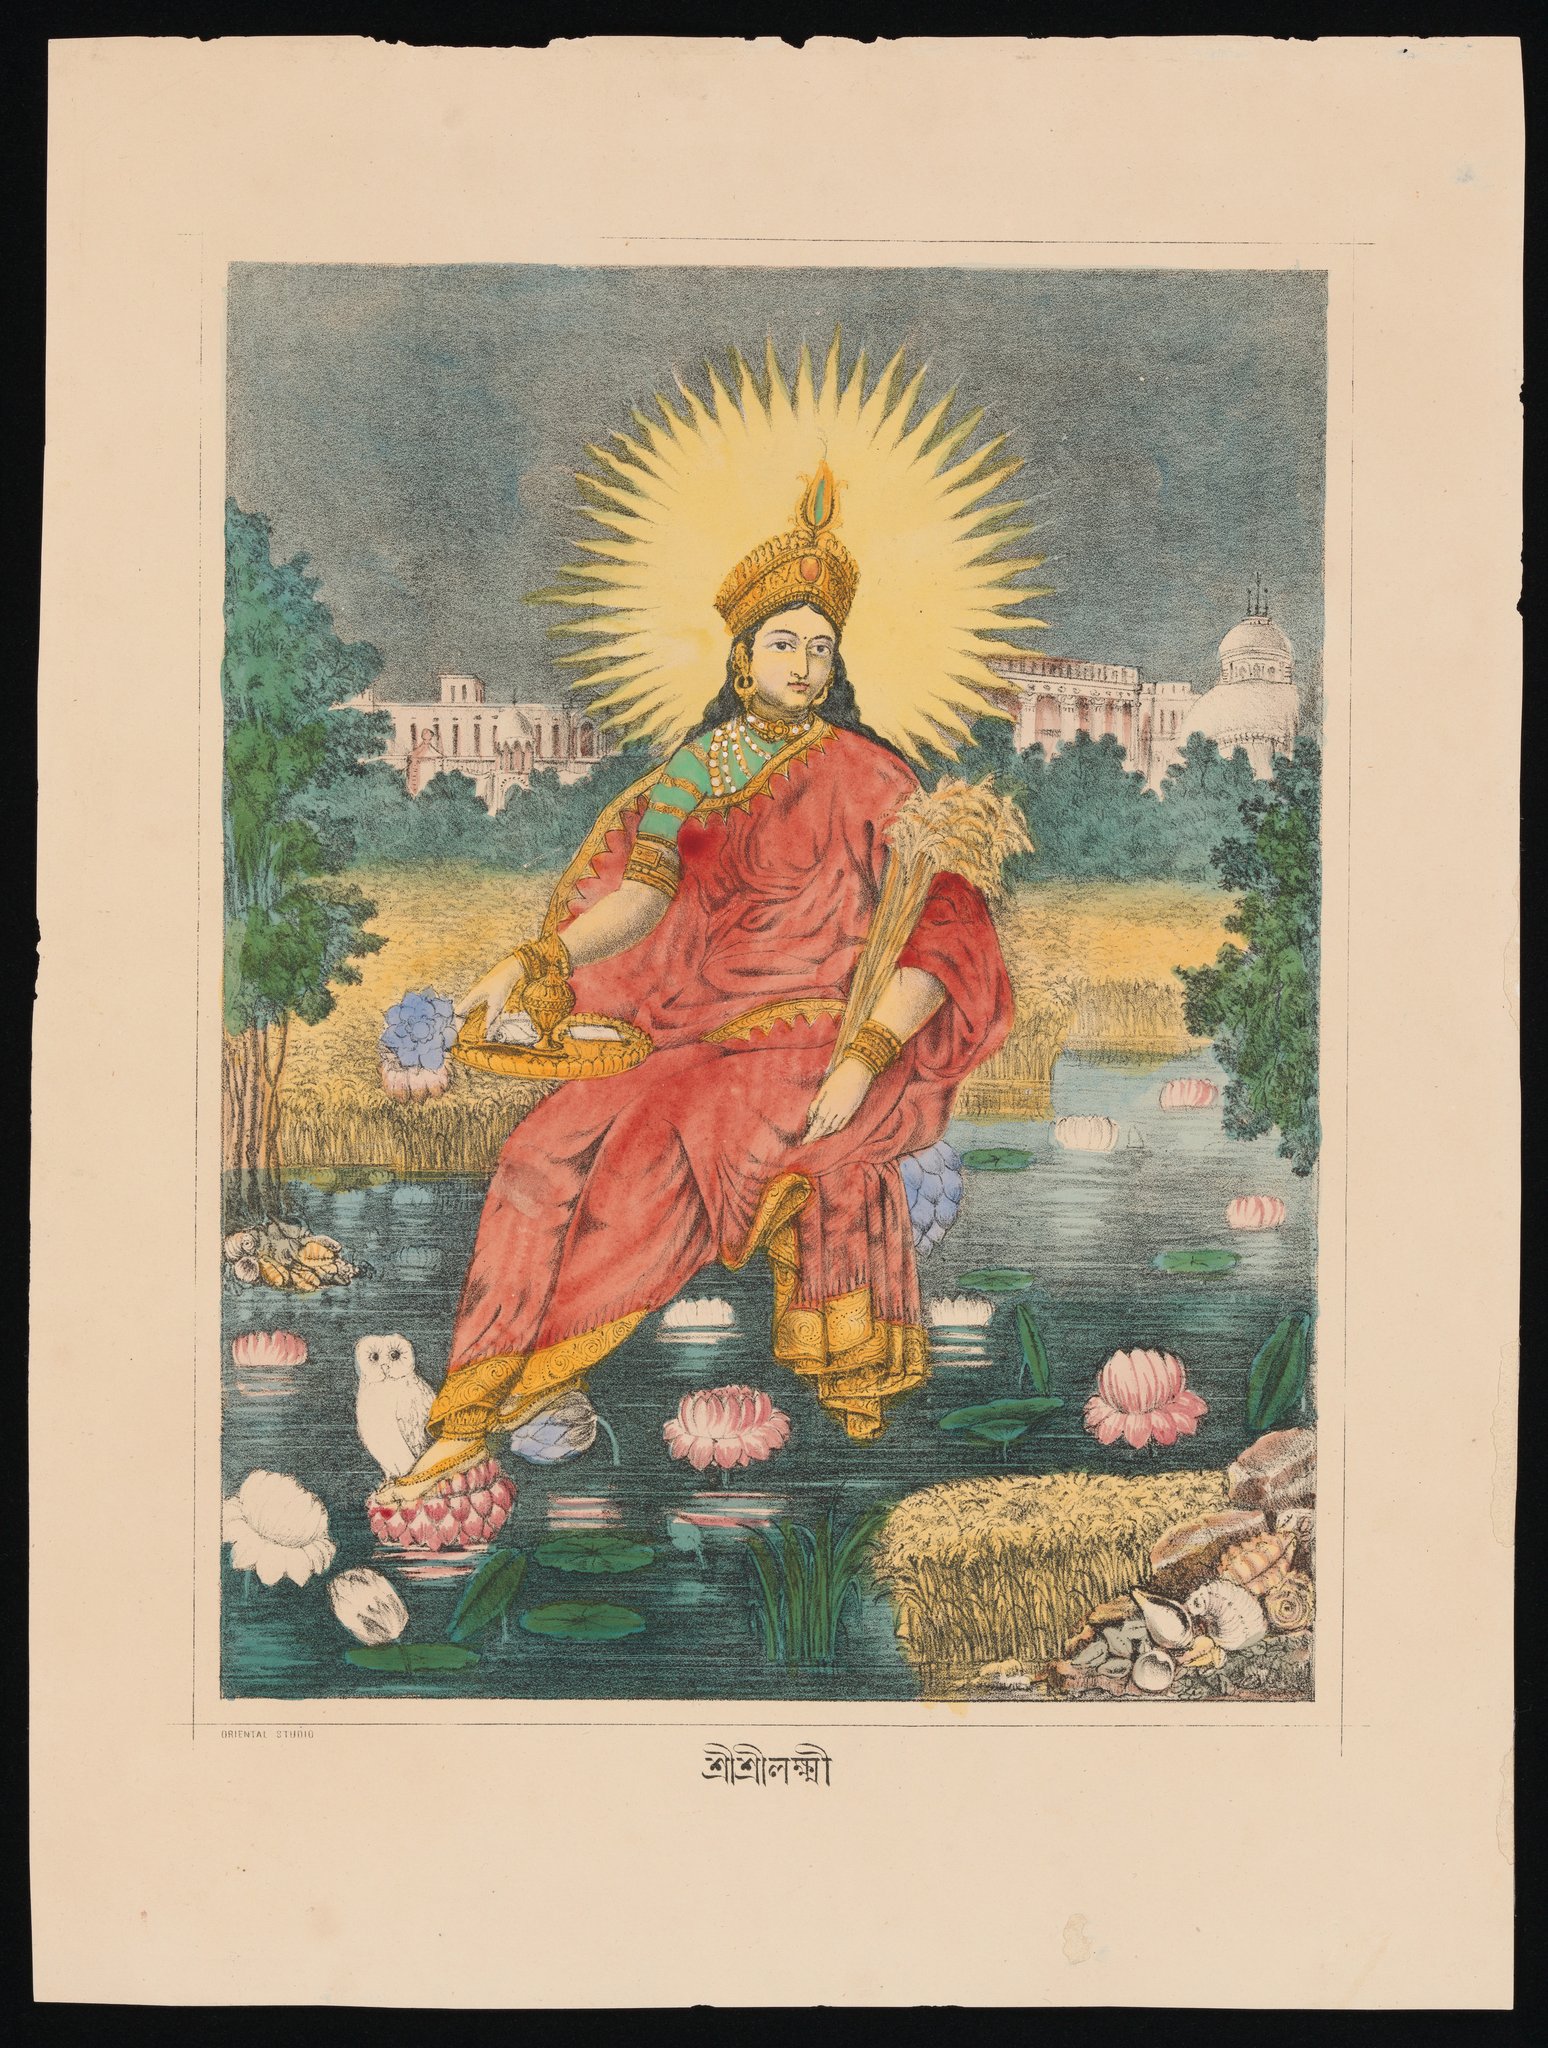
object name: lithograph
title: Shri Shri Lakshmi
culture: indian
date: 1880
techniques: hand coloring, lithograph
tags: owls,lotuses,goddess